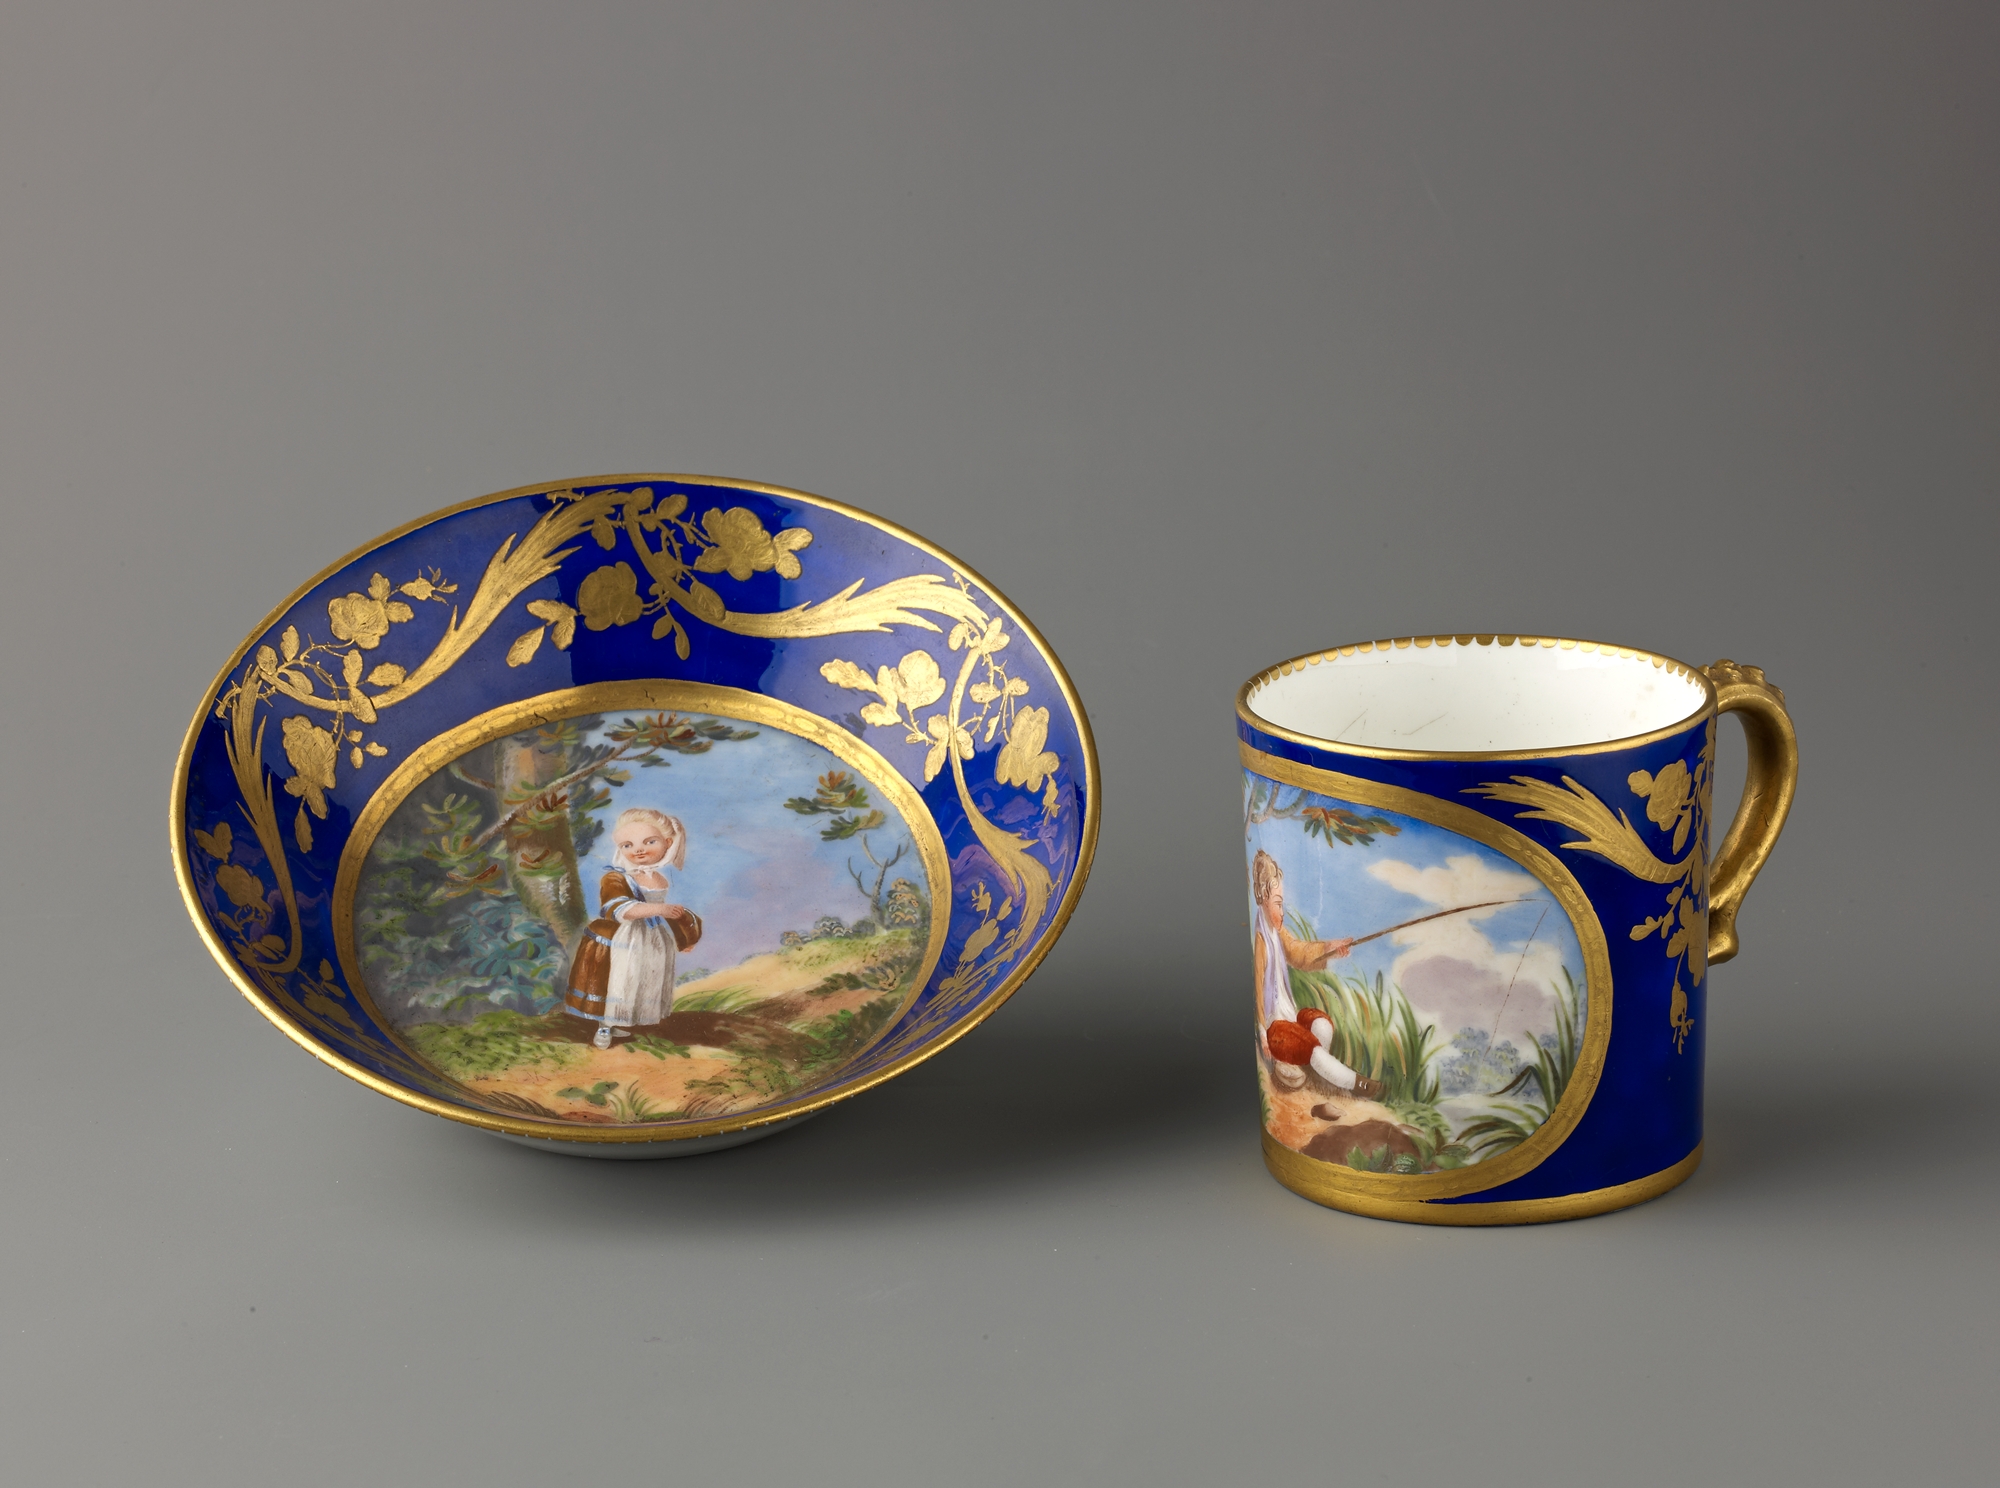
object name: cup and saucer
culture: french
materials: soft paste porcelain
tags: boys,girls,fishing